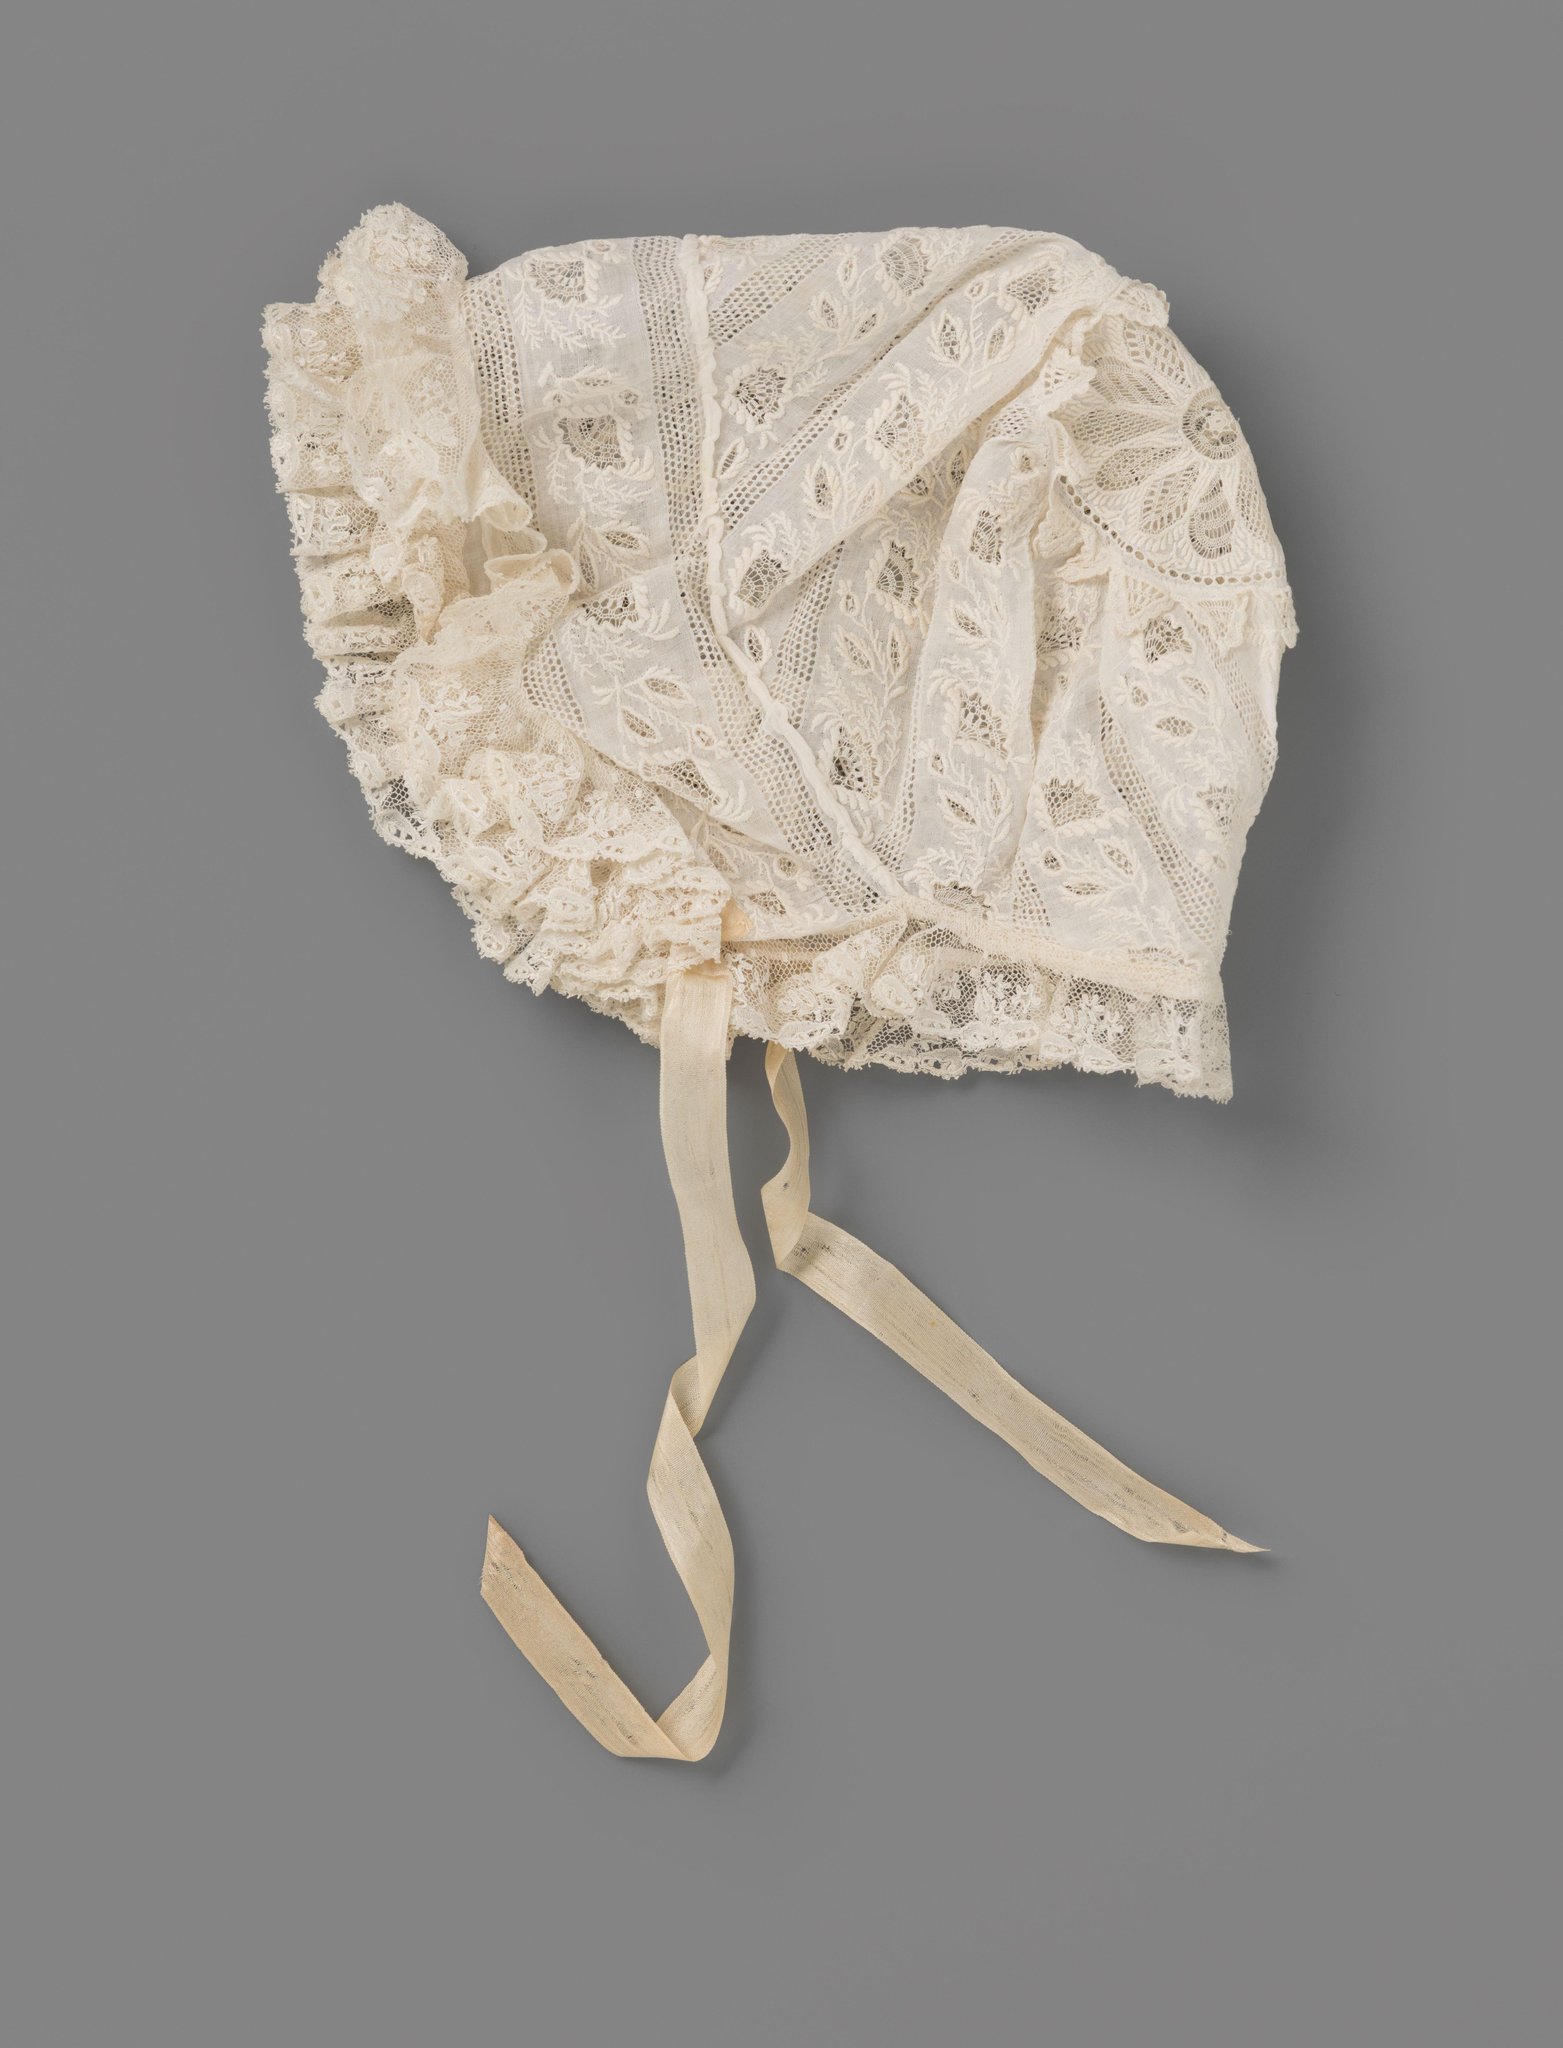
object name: childrenswear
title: Kindermuts van wit neteldoek versierd met witwerk en fils tirés, en afgezet met stroken Mechelse kant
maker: Anonymous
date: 1800-1850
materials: textile, ribbon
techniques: lace, embroidery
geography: netherlands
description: Kindermuts van witte neteldoek. Het rondsel op de kruin is versierd met witwerk en fils tirés. De mutsenbol bestaat uit schuine banen van geborduurde neteldoek. De voorhoofdstrook is eveneens van geborduurde neteldoek. Deze strook is afgezet met stroken gerimpelde Mechelse kant. Twee linten dienen als kinnebanden.